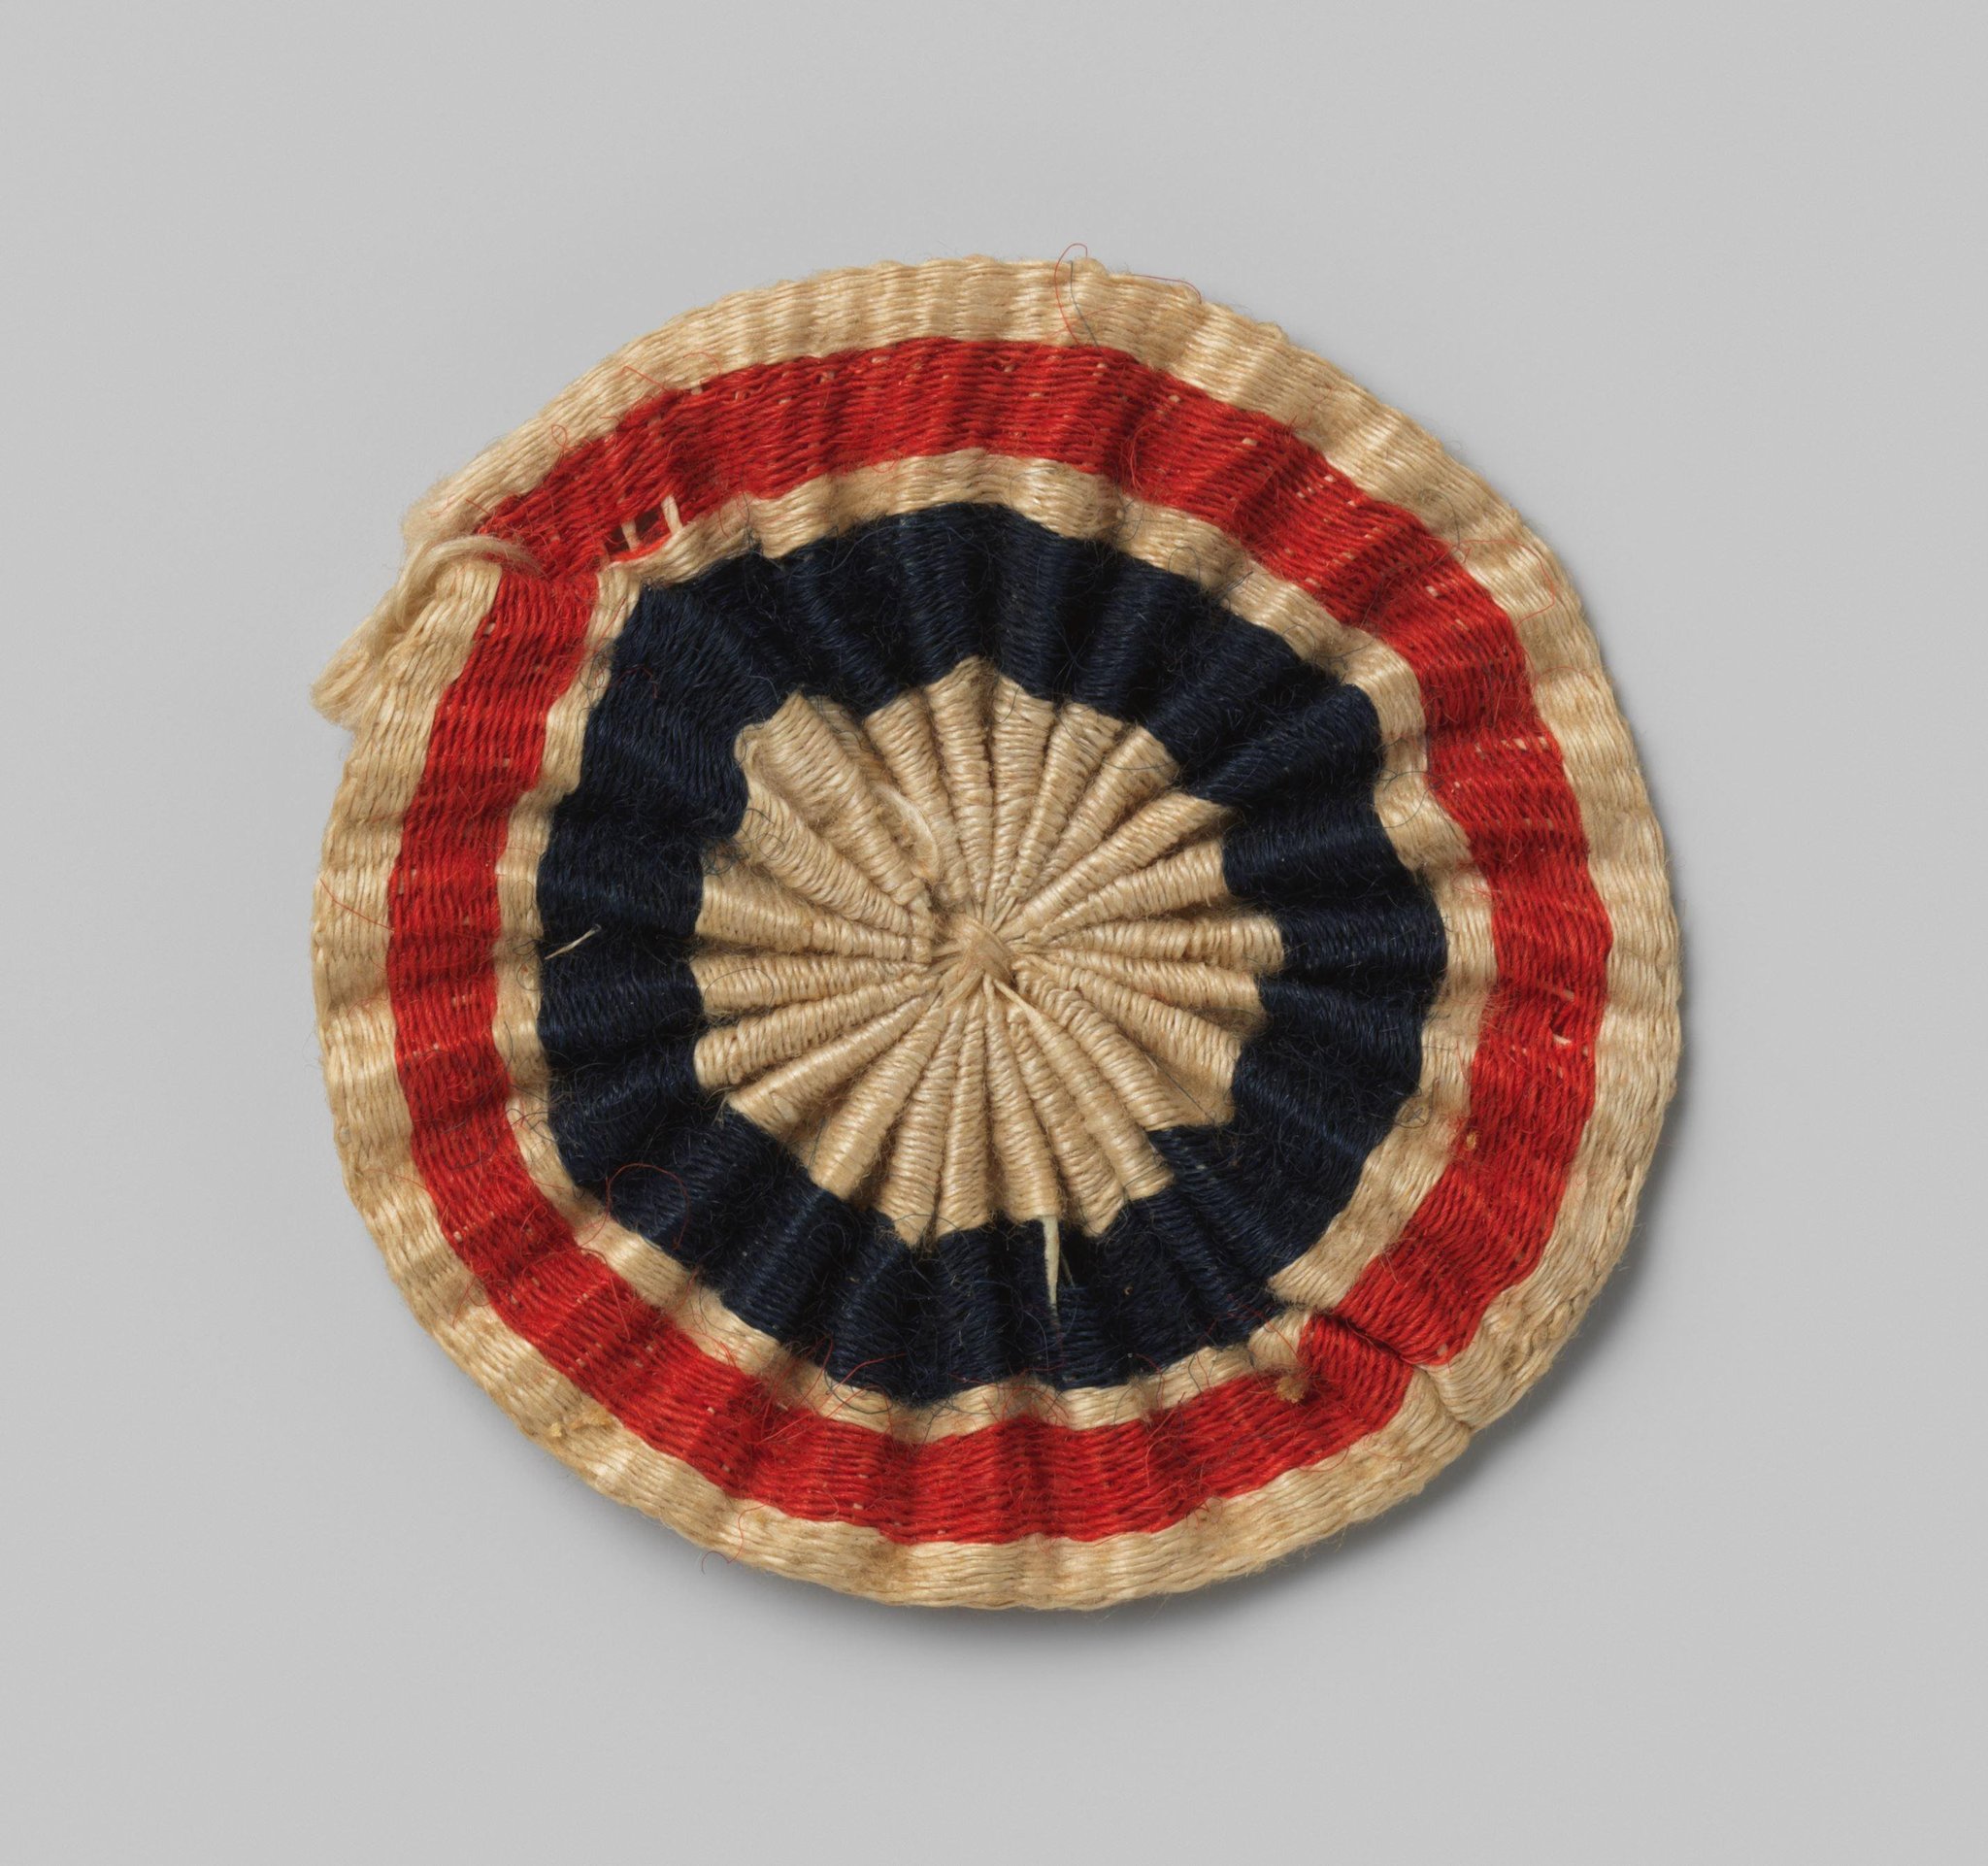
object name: rosette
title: Rozet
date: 1700-1800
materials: linen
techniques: stitching, weave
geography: netherlands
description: Rozet met de kleuren van buiten naar binnen: wit - rood - wit - blauw - wit.